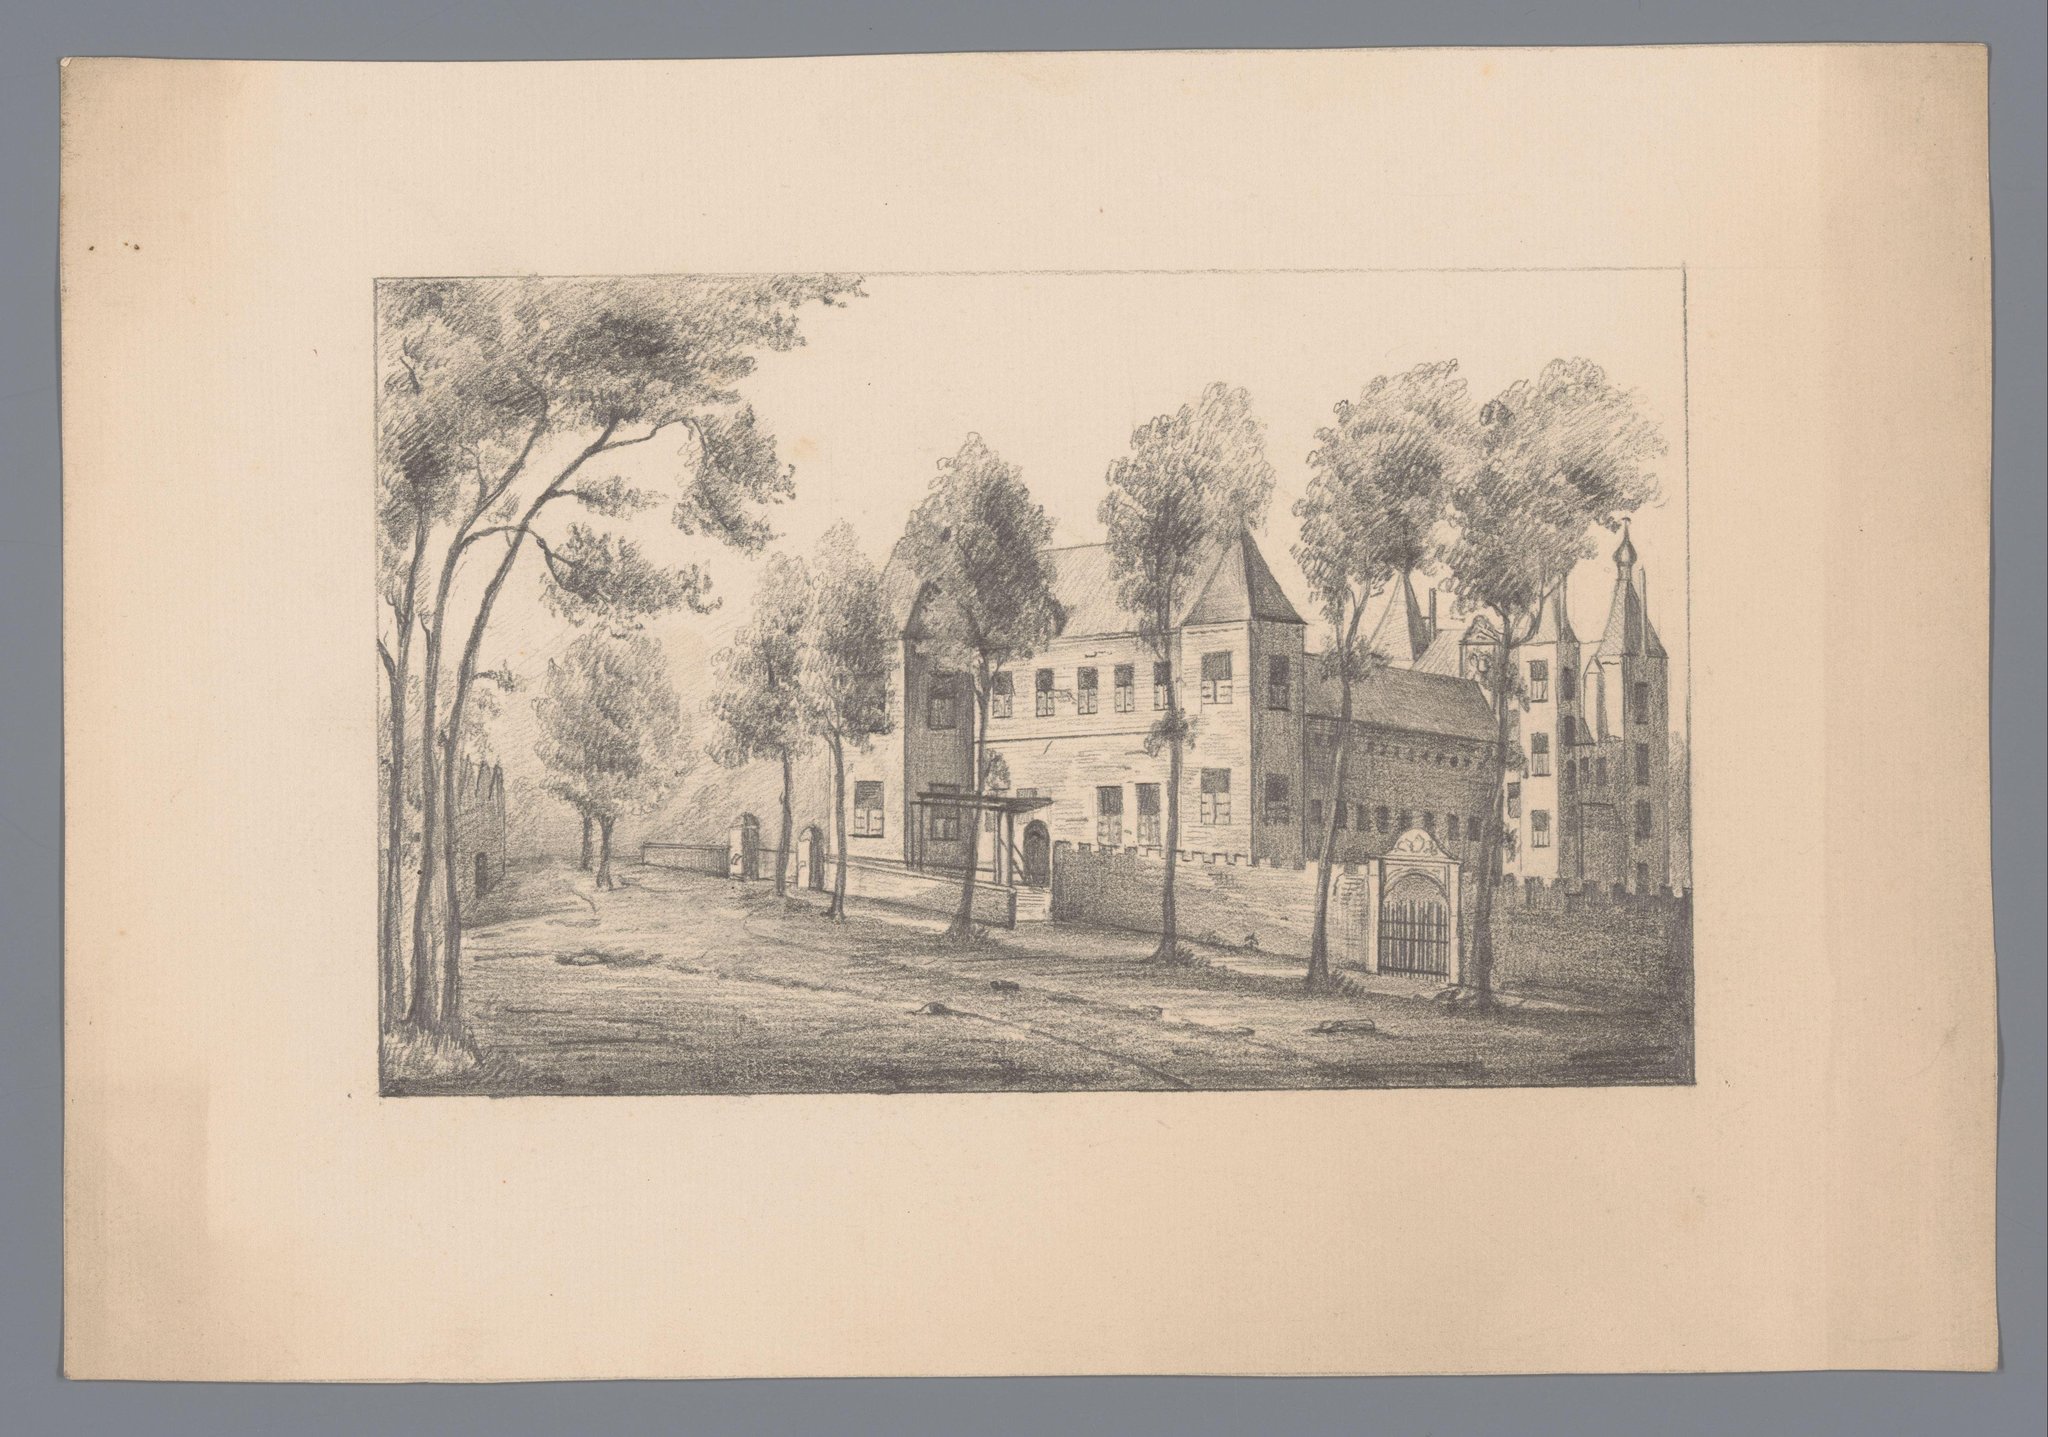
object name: drawing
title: Gezicht op Kasteel Develstein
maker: Anonymous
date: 1825-1925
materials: paper, pencil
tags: castle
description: Tekening behoort samen met nog een tekening van het kasteel (RP-T-2019-124-1) bij een blad met daarop handgeschreven de geschiedenis en geslachten van de eigenaren van kasteel Develstein.